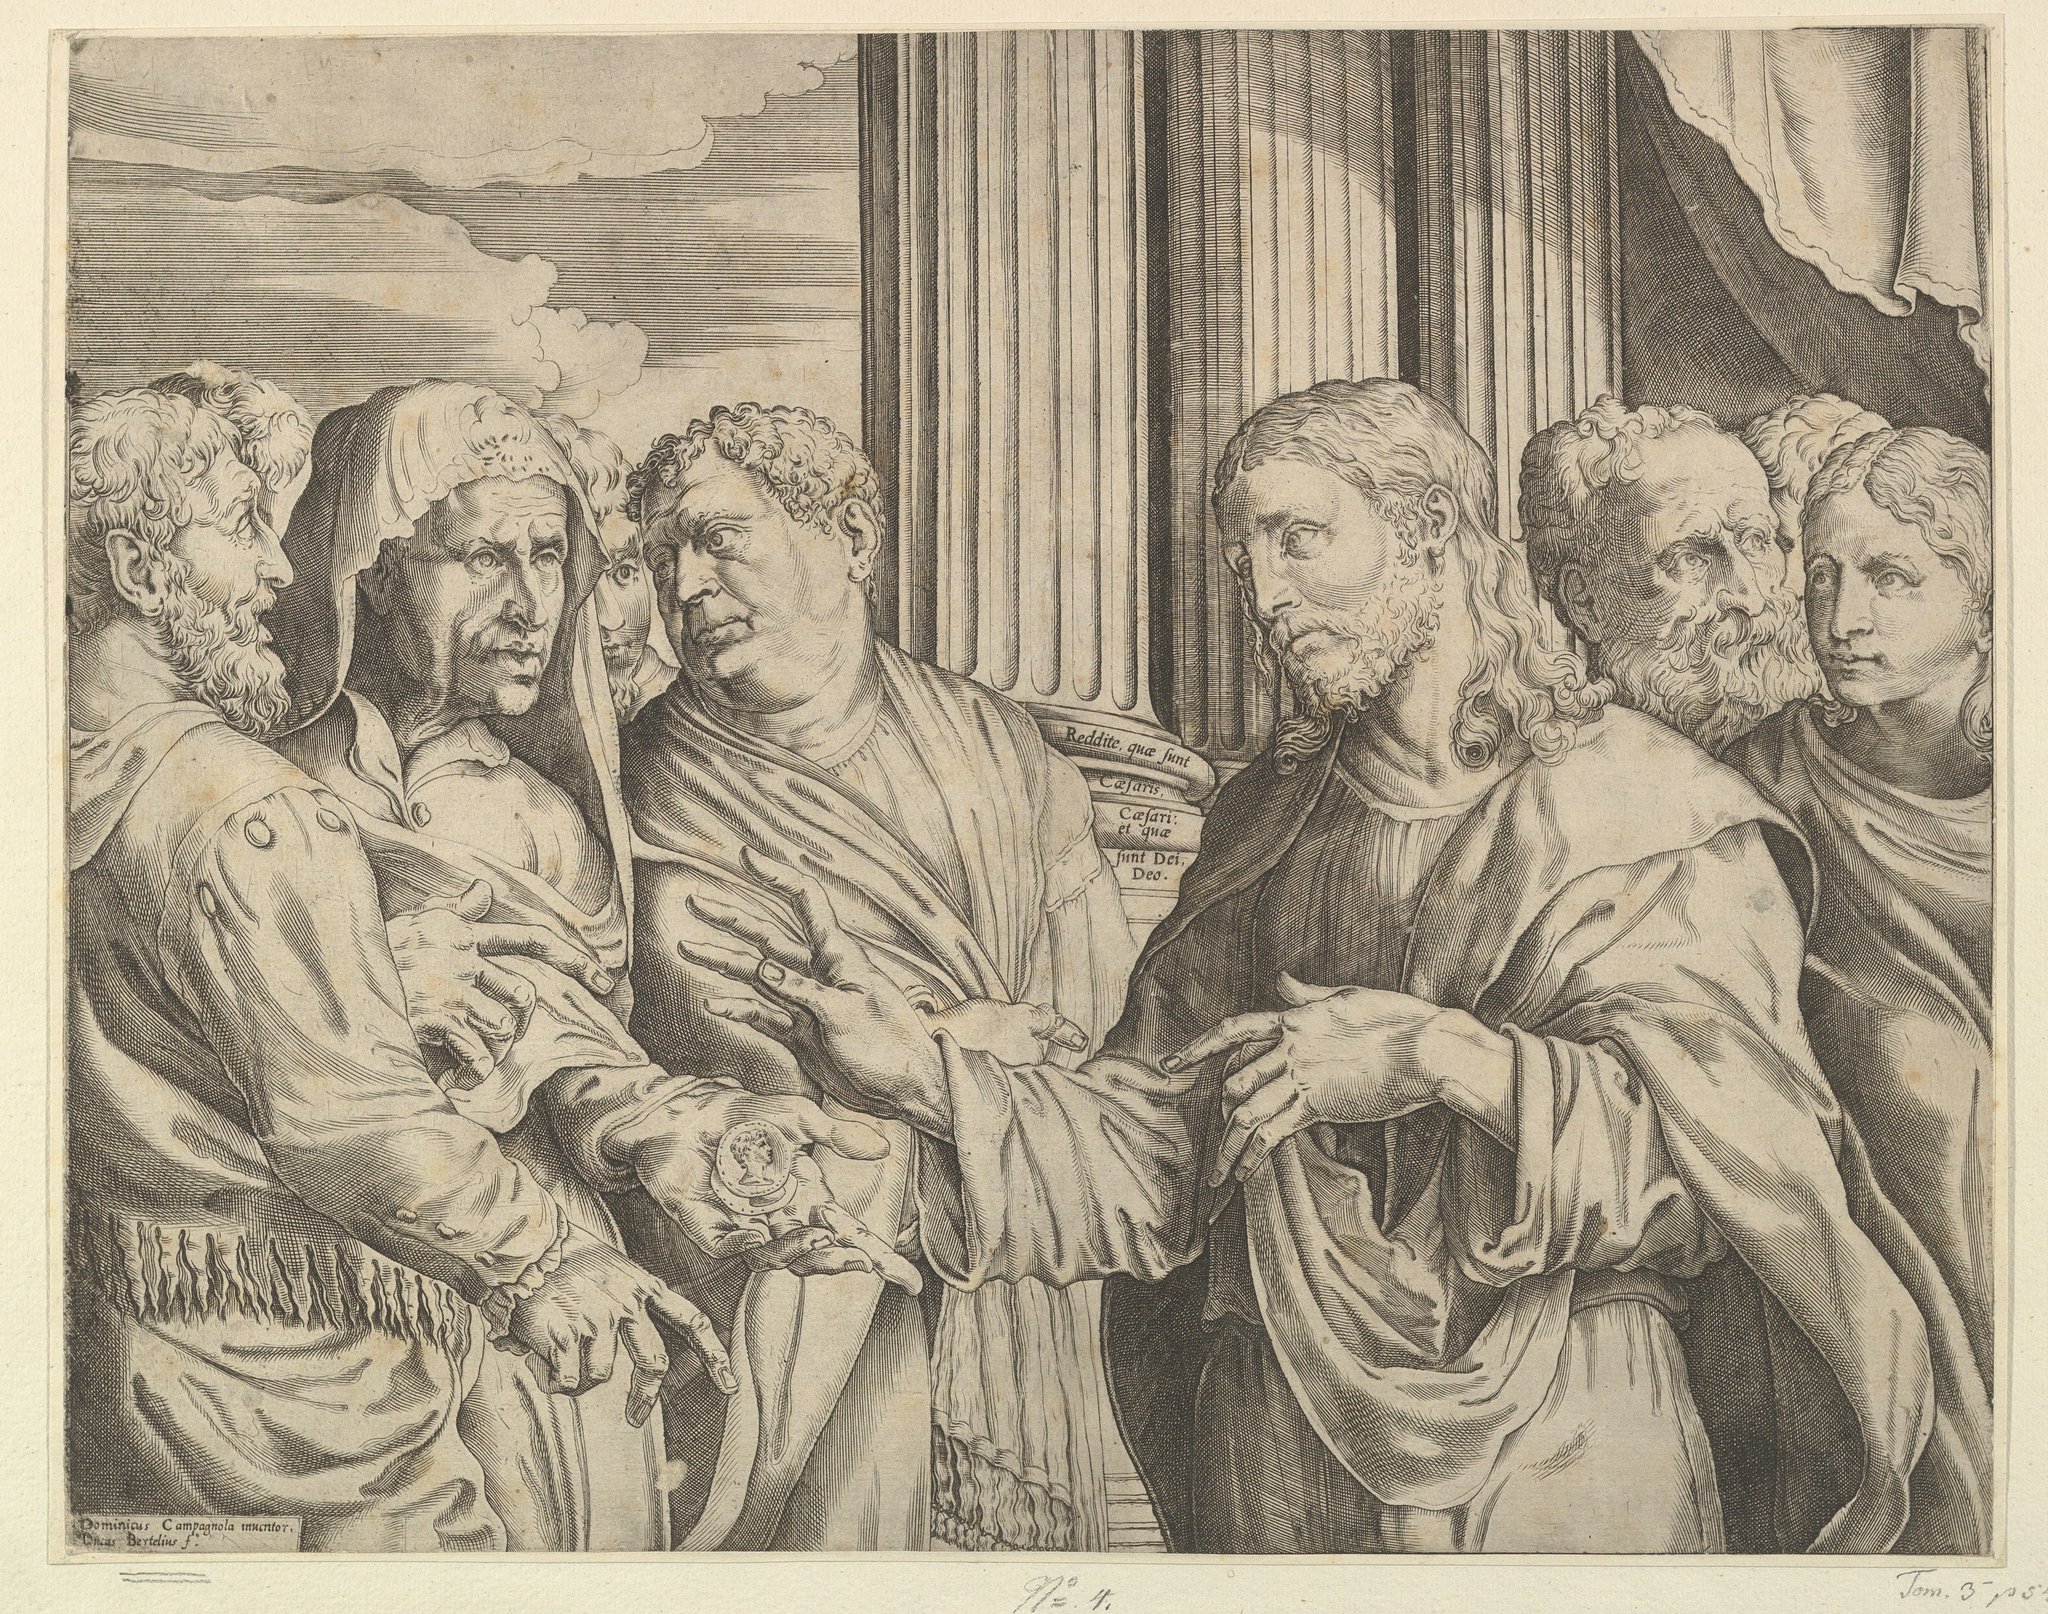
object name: print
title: The Triubute Money: Christ at center right gesturing to man at his left with coins in his hand, other figures surrounding them; columns and drapery in the background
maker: domenico campagnola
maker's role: artist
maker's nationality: italian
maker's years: 1500-1564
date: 1564-1589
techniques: engraving, etching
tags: men,christ,coins